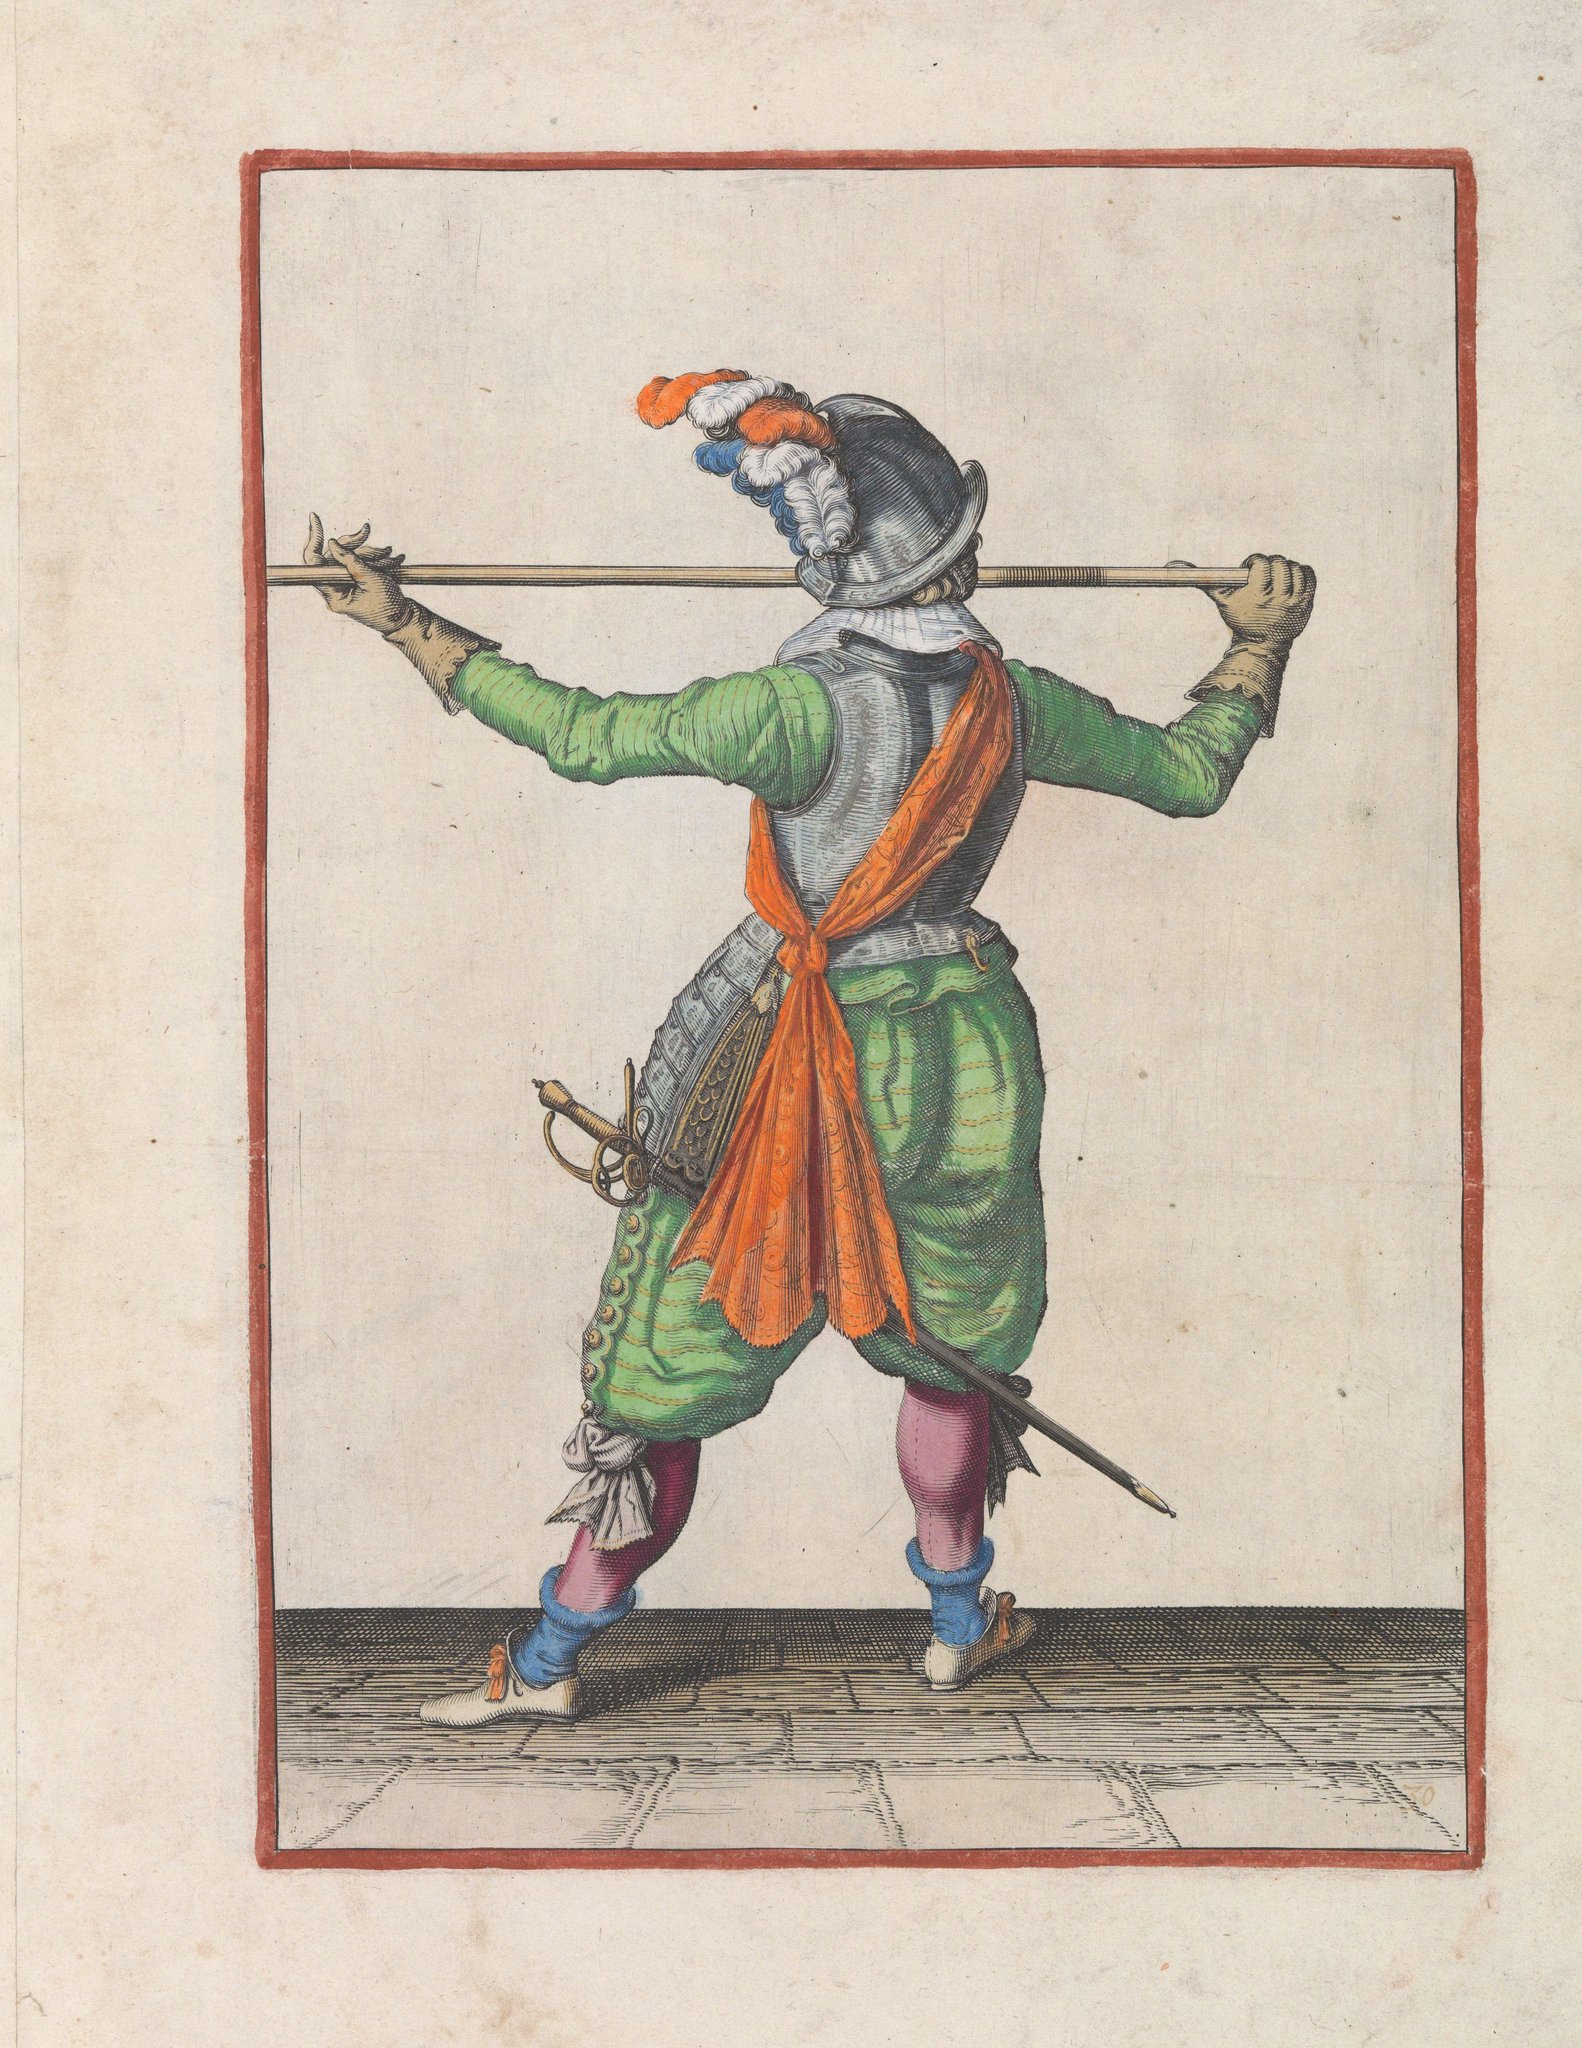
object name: print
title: Corte onderwysinghe op de figuerliicke afbeeldinghe, belanghende t'recht ghebruyck, van al t'ghene een Soldaet int handelen vande Spies noodich is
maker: jacques de gheyn (ii)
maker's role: painter, print maker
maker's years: 1565-1629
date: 1597-1607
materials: paper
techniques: engraving, hand coloring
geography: the hague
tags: handling of weapons ~ military training, helved weapons, polearms (for striking, hacking, thrusting): lance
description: Een soldaat, ten voeten uit, op de rug gezien, die een spies (lans) met beide handen horizontaal op neushoogte draagt, zijn rechterhand bij de voet van het wapen, zijn gezicht naar rechts gewend. Deze prent is onderdeel van de reeks van 32 met de hand genummerde prenten van spiesdragers in de Wapenhandelinghe.